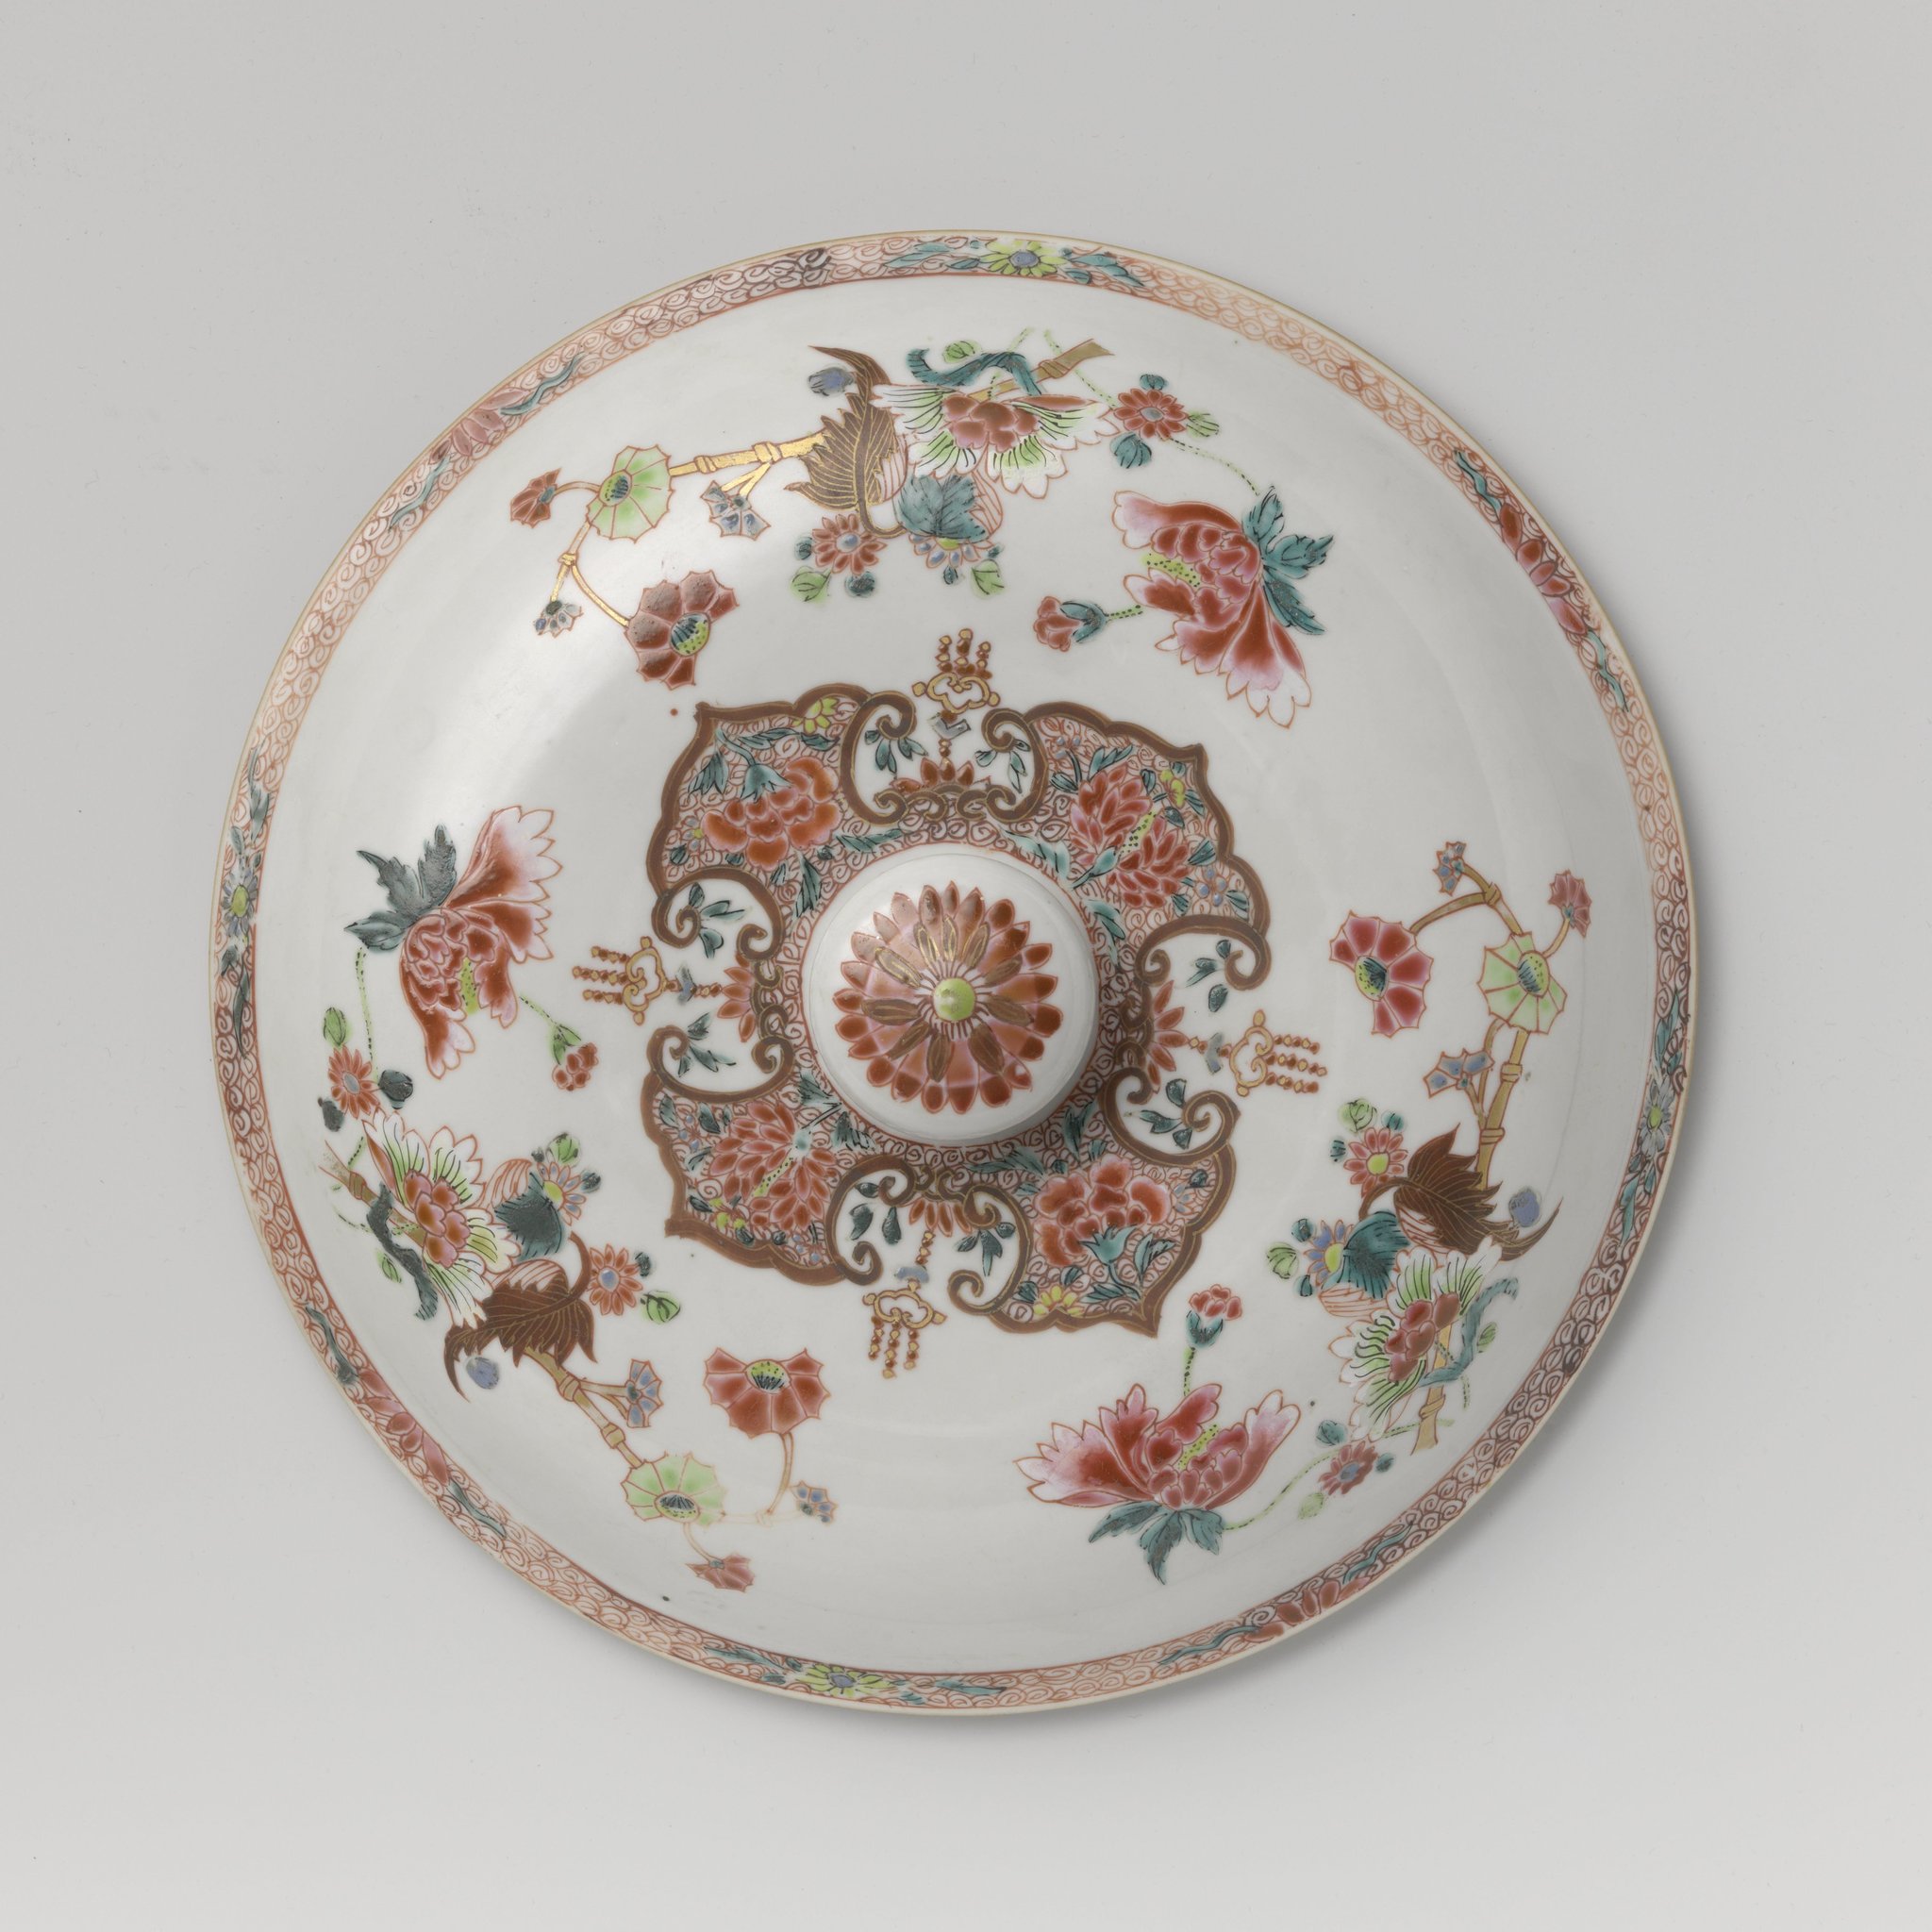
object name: lid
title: Covered tureen with groups of flowers and ornamental border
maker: Anonymous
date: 1800-1899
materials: glaze, gold, paint, porcelain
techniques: firing, gilding, turning, vitrification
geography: china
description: Schaal met deksel van porselein beschilderd in famille rose met lambrequins en bloemen.